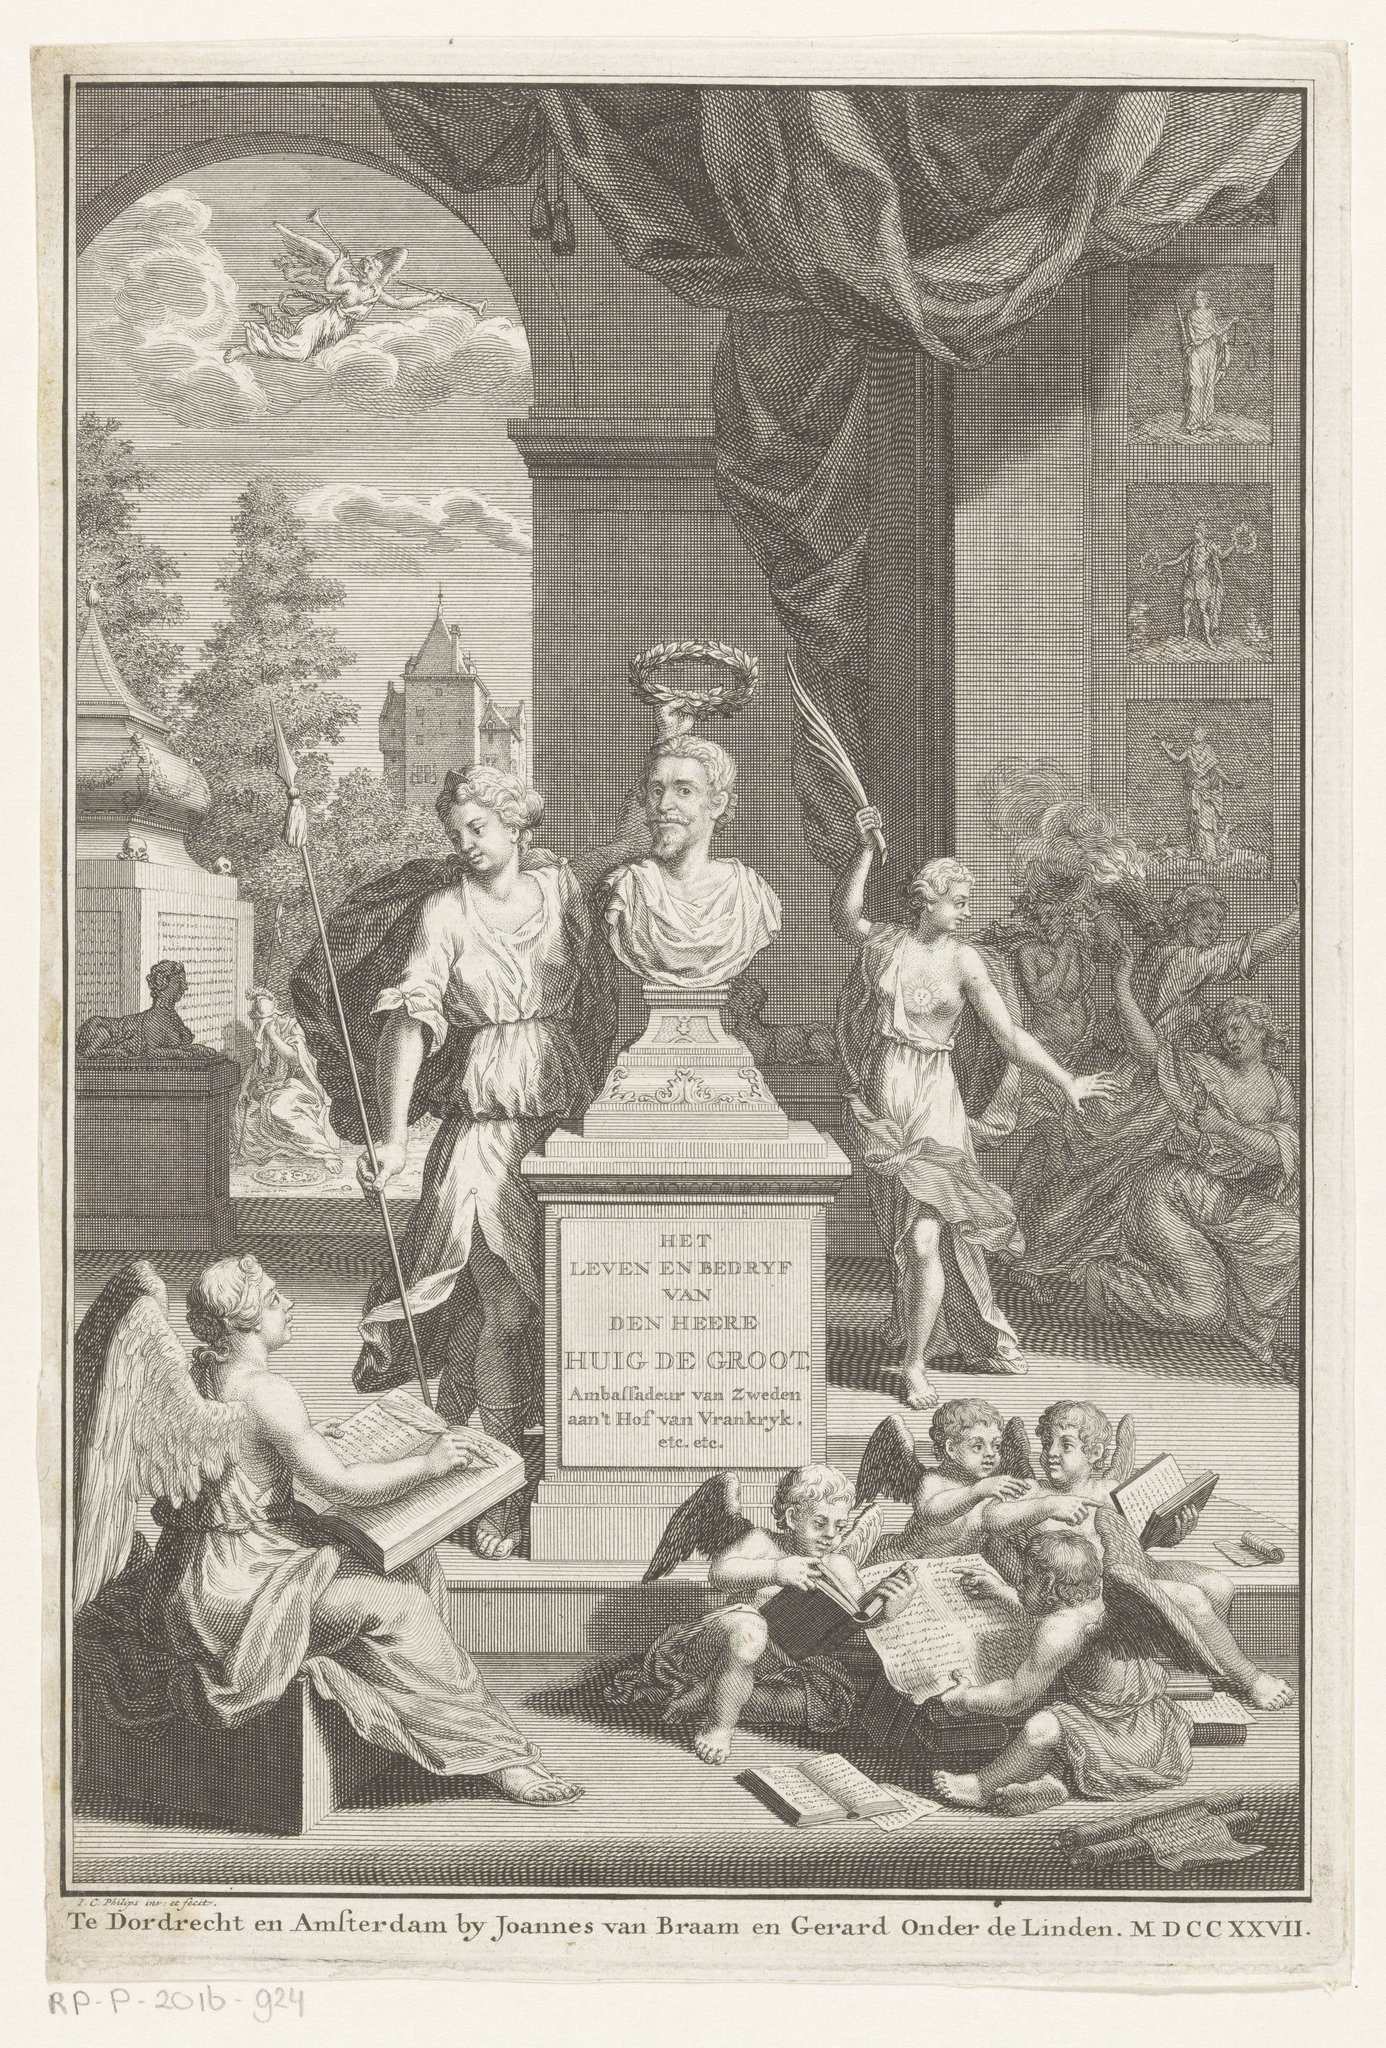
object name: titelblad, titelpagina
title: Buste van Hugo de Groot gelauwerd door Victoria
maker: jan caspar philips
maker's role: draughtsman, print maker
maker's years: 1700-1775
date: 1727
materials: paper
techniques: engraving, etching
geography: dordrecht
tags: delft, hugo de groot, fides (faith) as roman personification, victoria as roman personification, portrait of a writer, angels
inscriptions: collector's mark: Lugt 2228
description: Een buste van Hugo de Groot wordt gelauwerd door Victoria. Rechts staat een allegorische vrouwenfiguur, mogelijk Geloof, met palmtak en zon op haar borst. Op de voorgrond schrijft een engel in een boek, rechts putti met boeken. Links in de achtergrond Minerva treurend bij een grafmonument, Slot Loevestein en Fama met twee bazuinen.